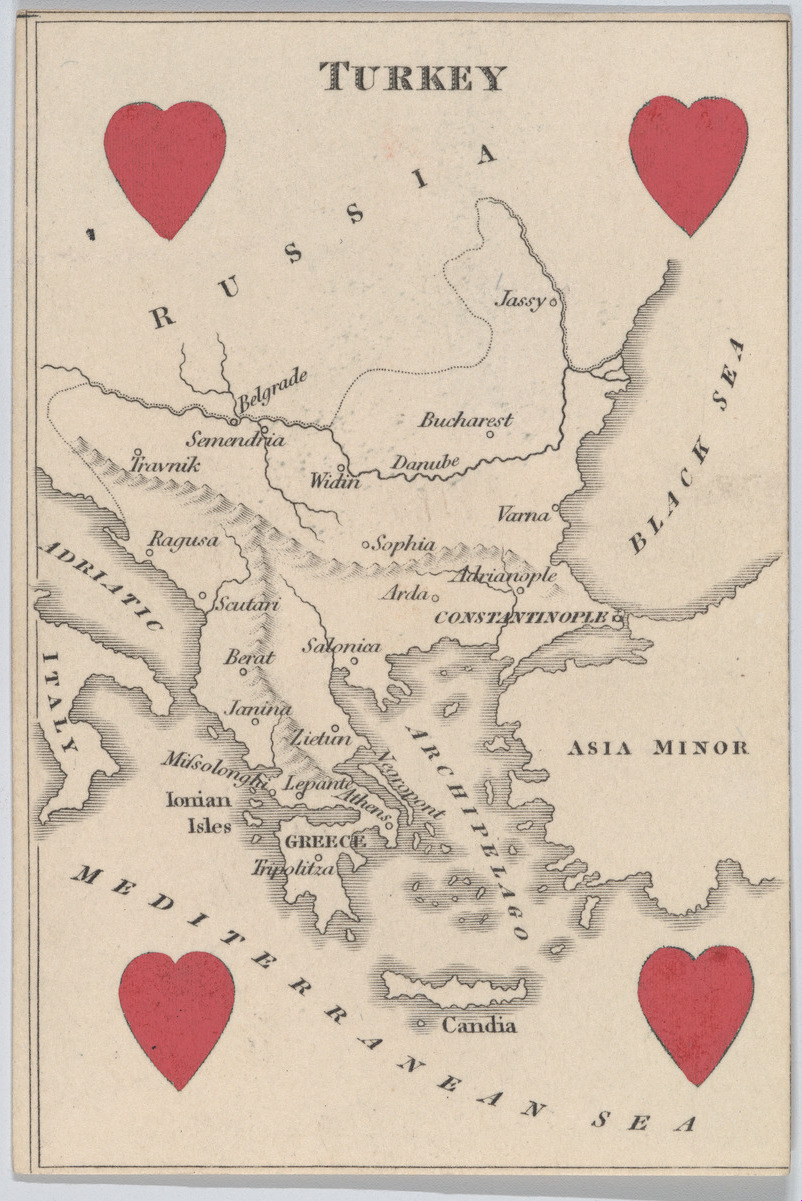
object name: print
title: Turkey, from "Court Game of Geography"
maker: william and henry rock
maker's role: publisher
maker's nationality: british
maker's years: 1821-1884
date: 1838-1855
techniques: engraving, hand coloring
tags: playing cards,maps